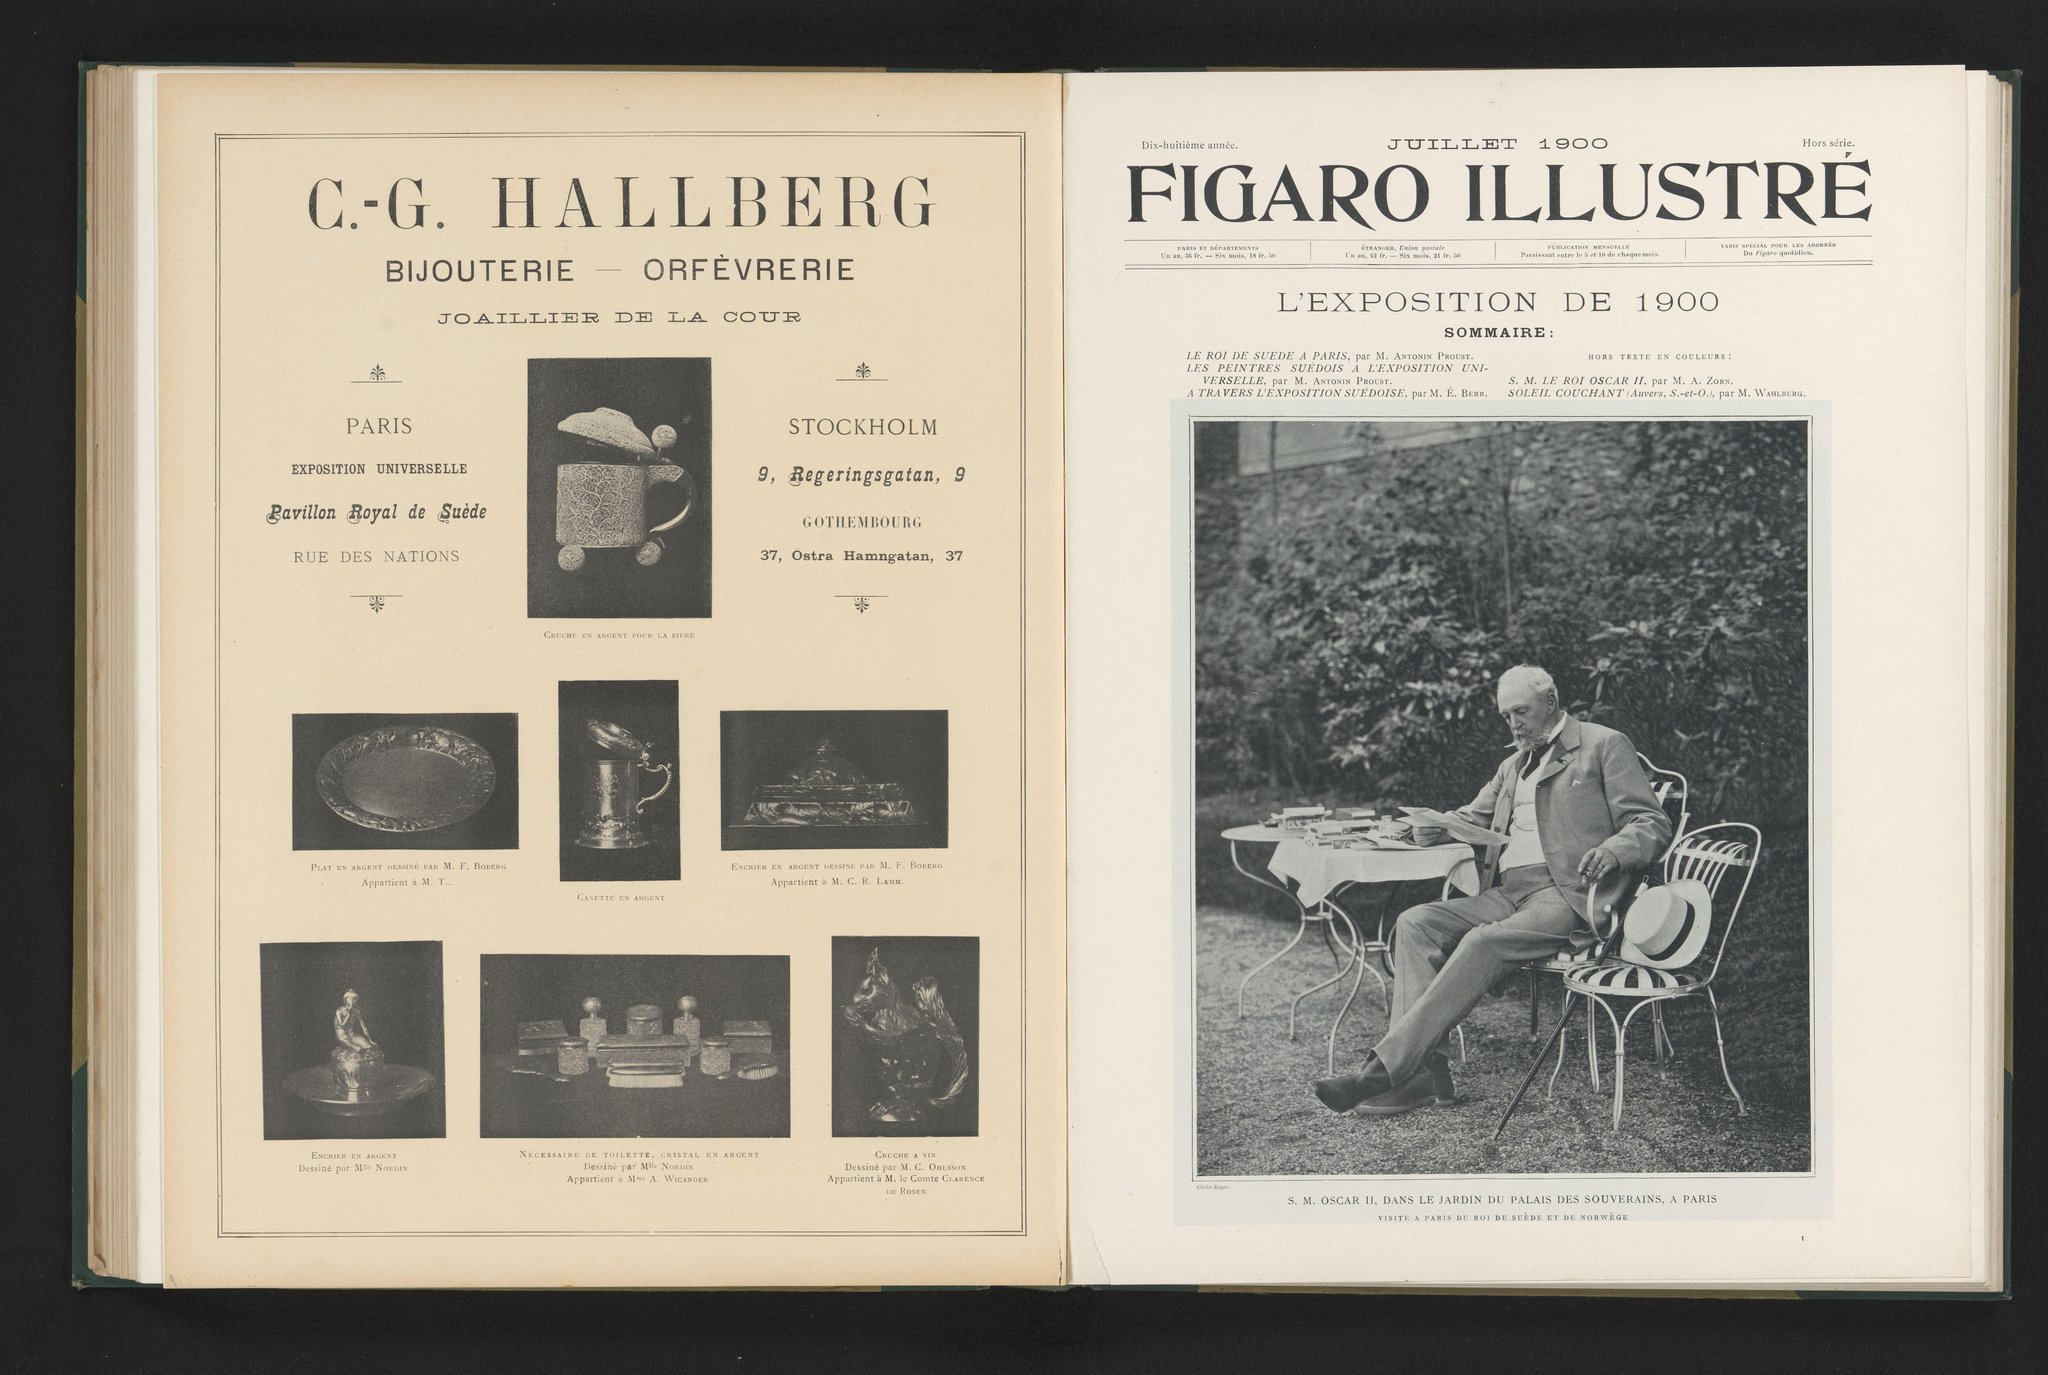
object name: photomechanical print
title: S.M. Oscar II, dans le jardin du Palais des Souverains, a Paris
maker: boyer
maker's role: fotograaf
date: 1885-1901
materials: paper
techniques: autotype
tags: garden, historical persons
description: Prent op pagina 1 van Figaro-Illustré (Juillet 1900).